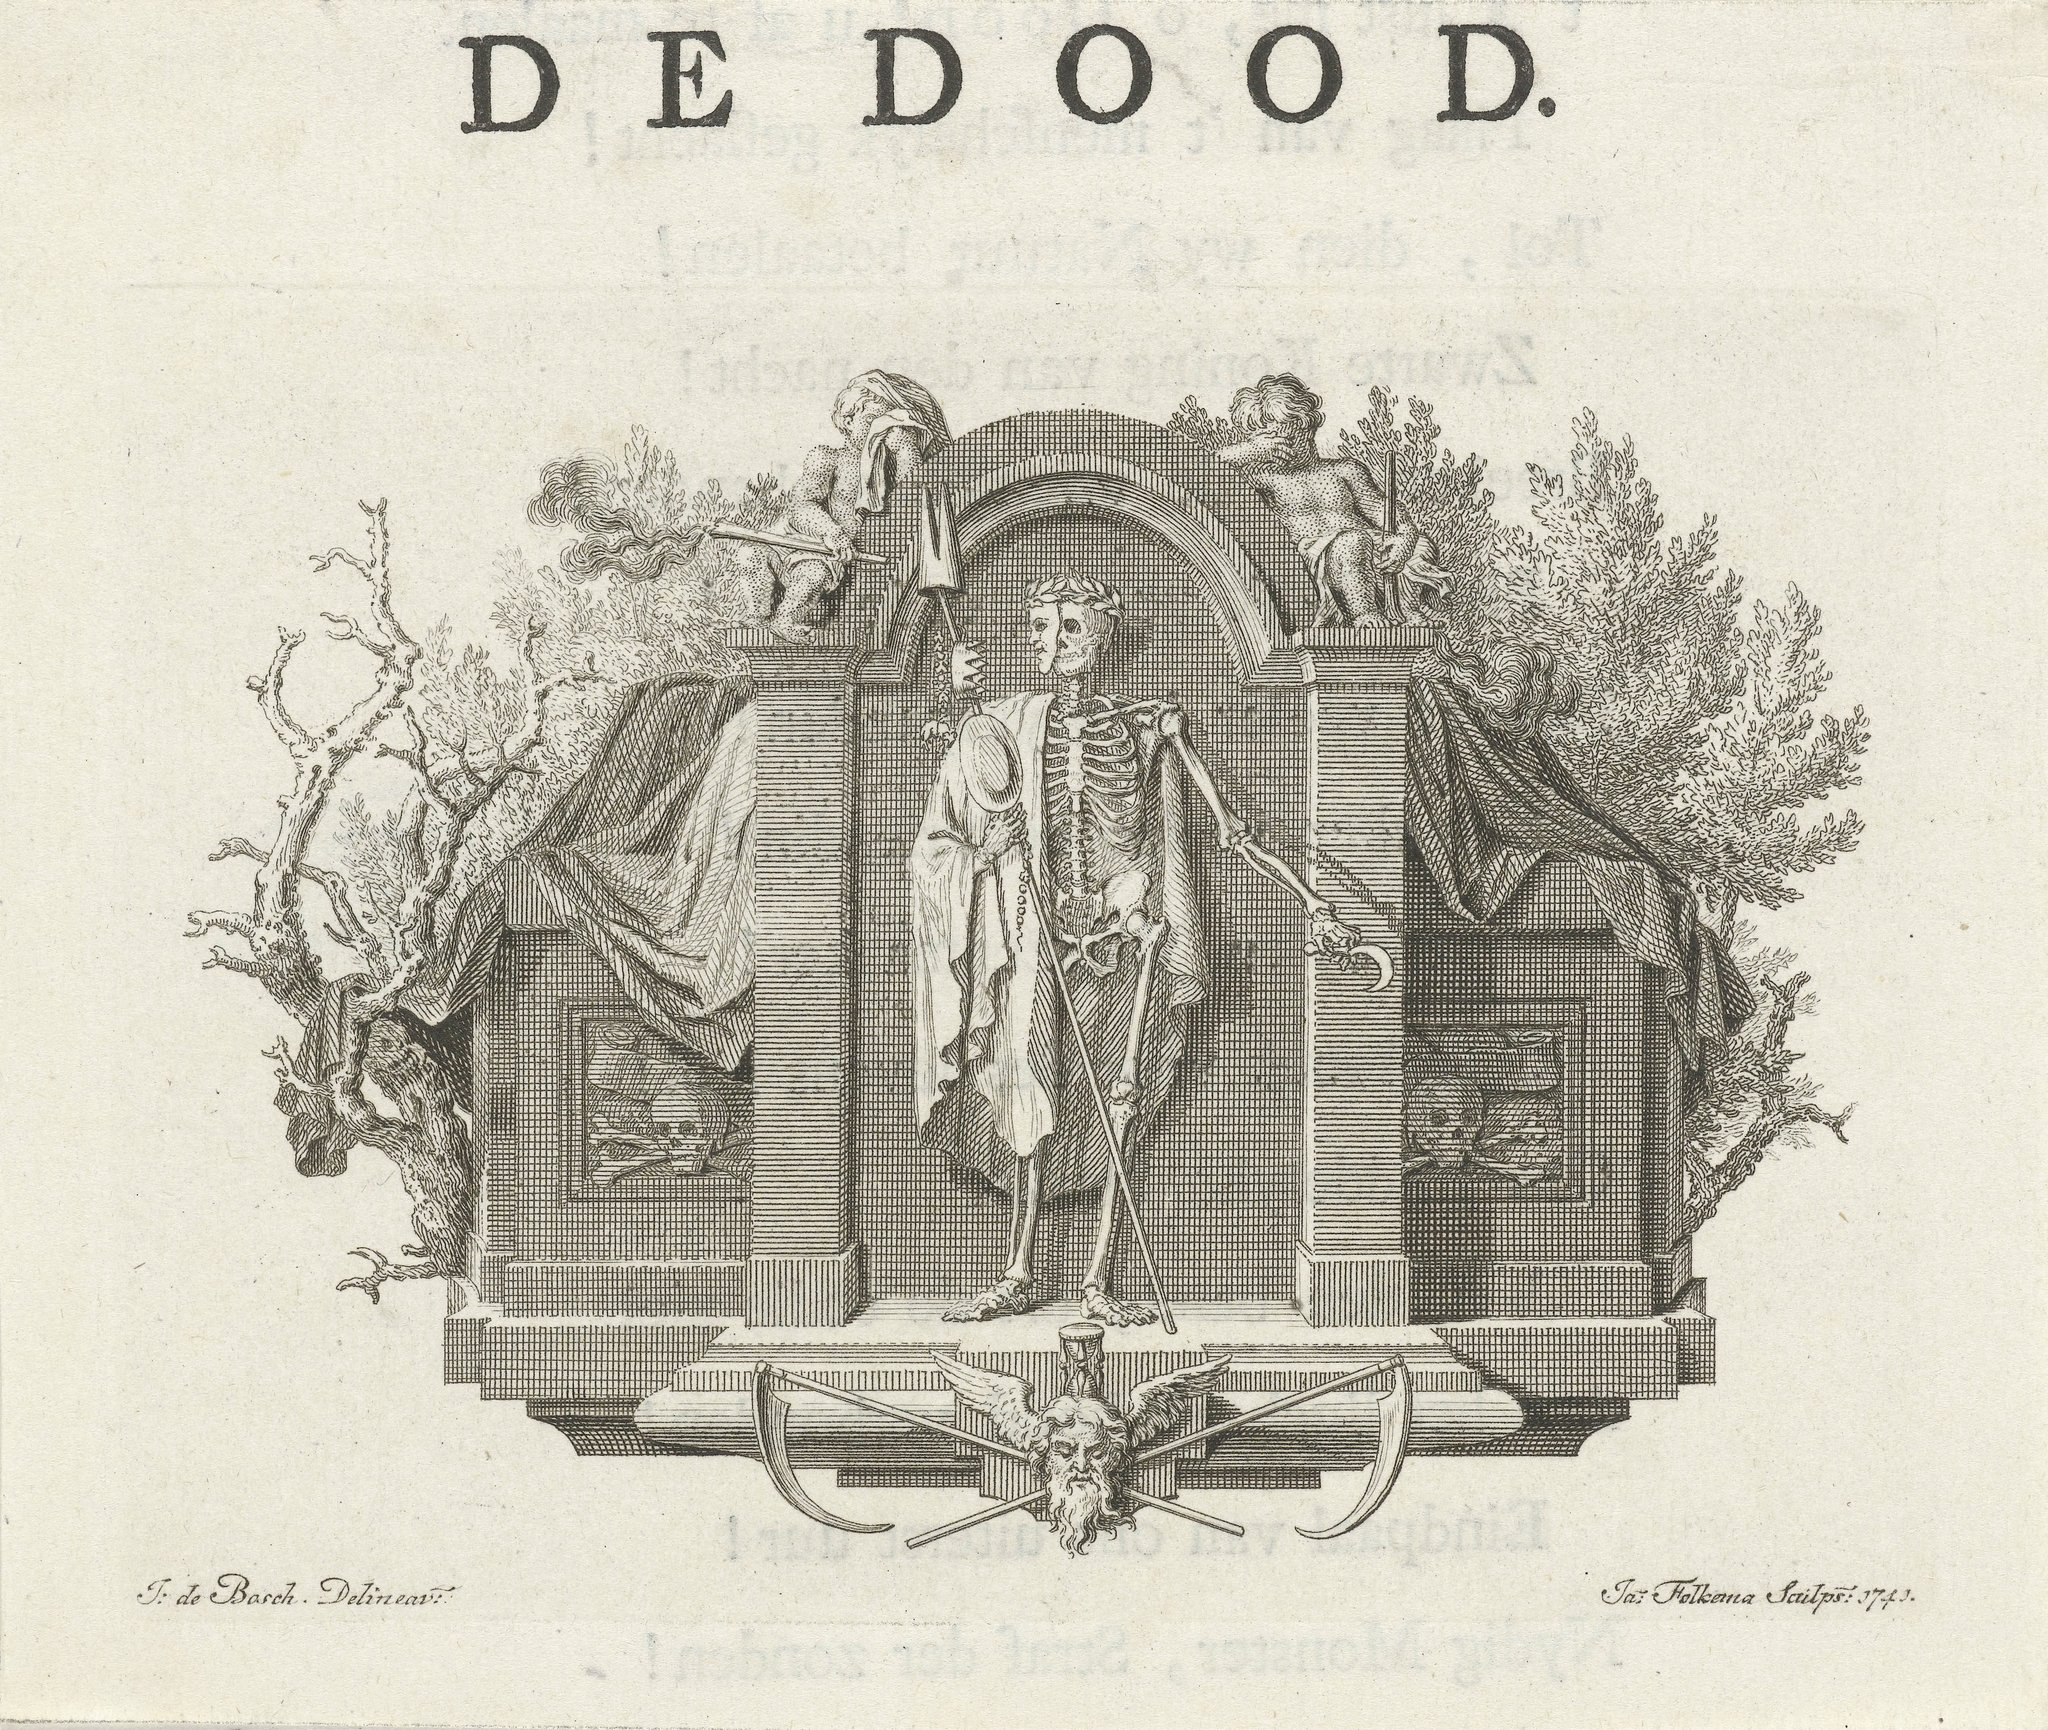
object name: book illustration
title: Deugden en ondeugden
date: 1741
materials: paper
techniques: etching, letterpress printing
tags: personifications of death; 'morte' (ripa)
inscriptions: collector's mark: Lugt 2228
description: Vignet met de beeltenis van de gepersonifieerde Dood. De Dood is een gedeeltelijk aangekleed skelet met een staf in zijn rechter- en een sikkel in zijn linkerhand. Zijn schedel is gelauwerd en voor de helft bedekt met een masker. Achter de dood treuren op een muur twee putti met brandende toortsen, onder de Dood staat een zandloper op het hoofd van Vader Tijd met twee gekruiste zeisen afgebeeld. De prent maakt deel uit van een reeks boekillustraties over deugden en ondeugden.